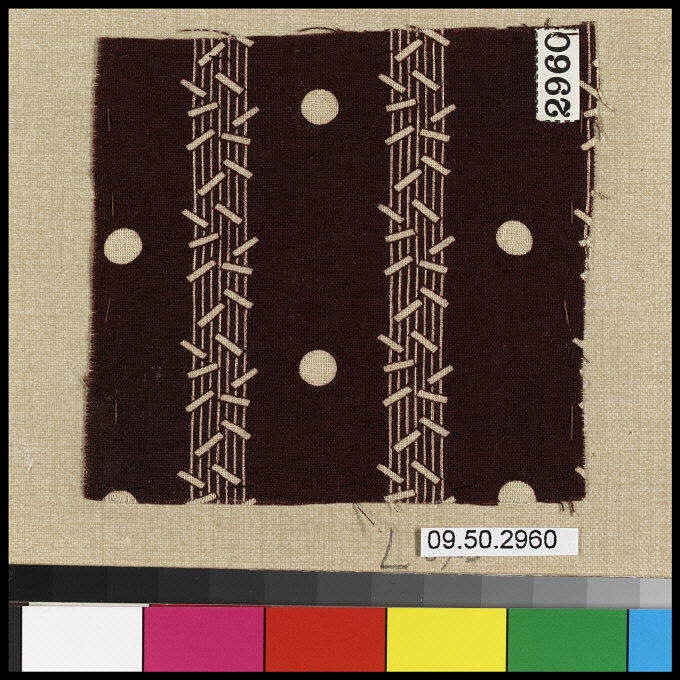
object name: piece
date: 1801-1900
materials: cotton